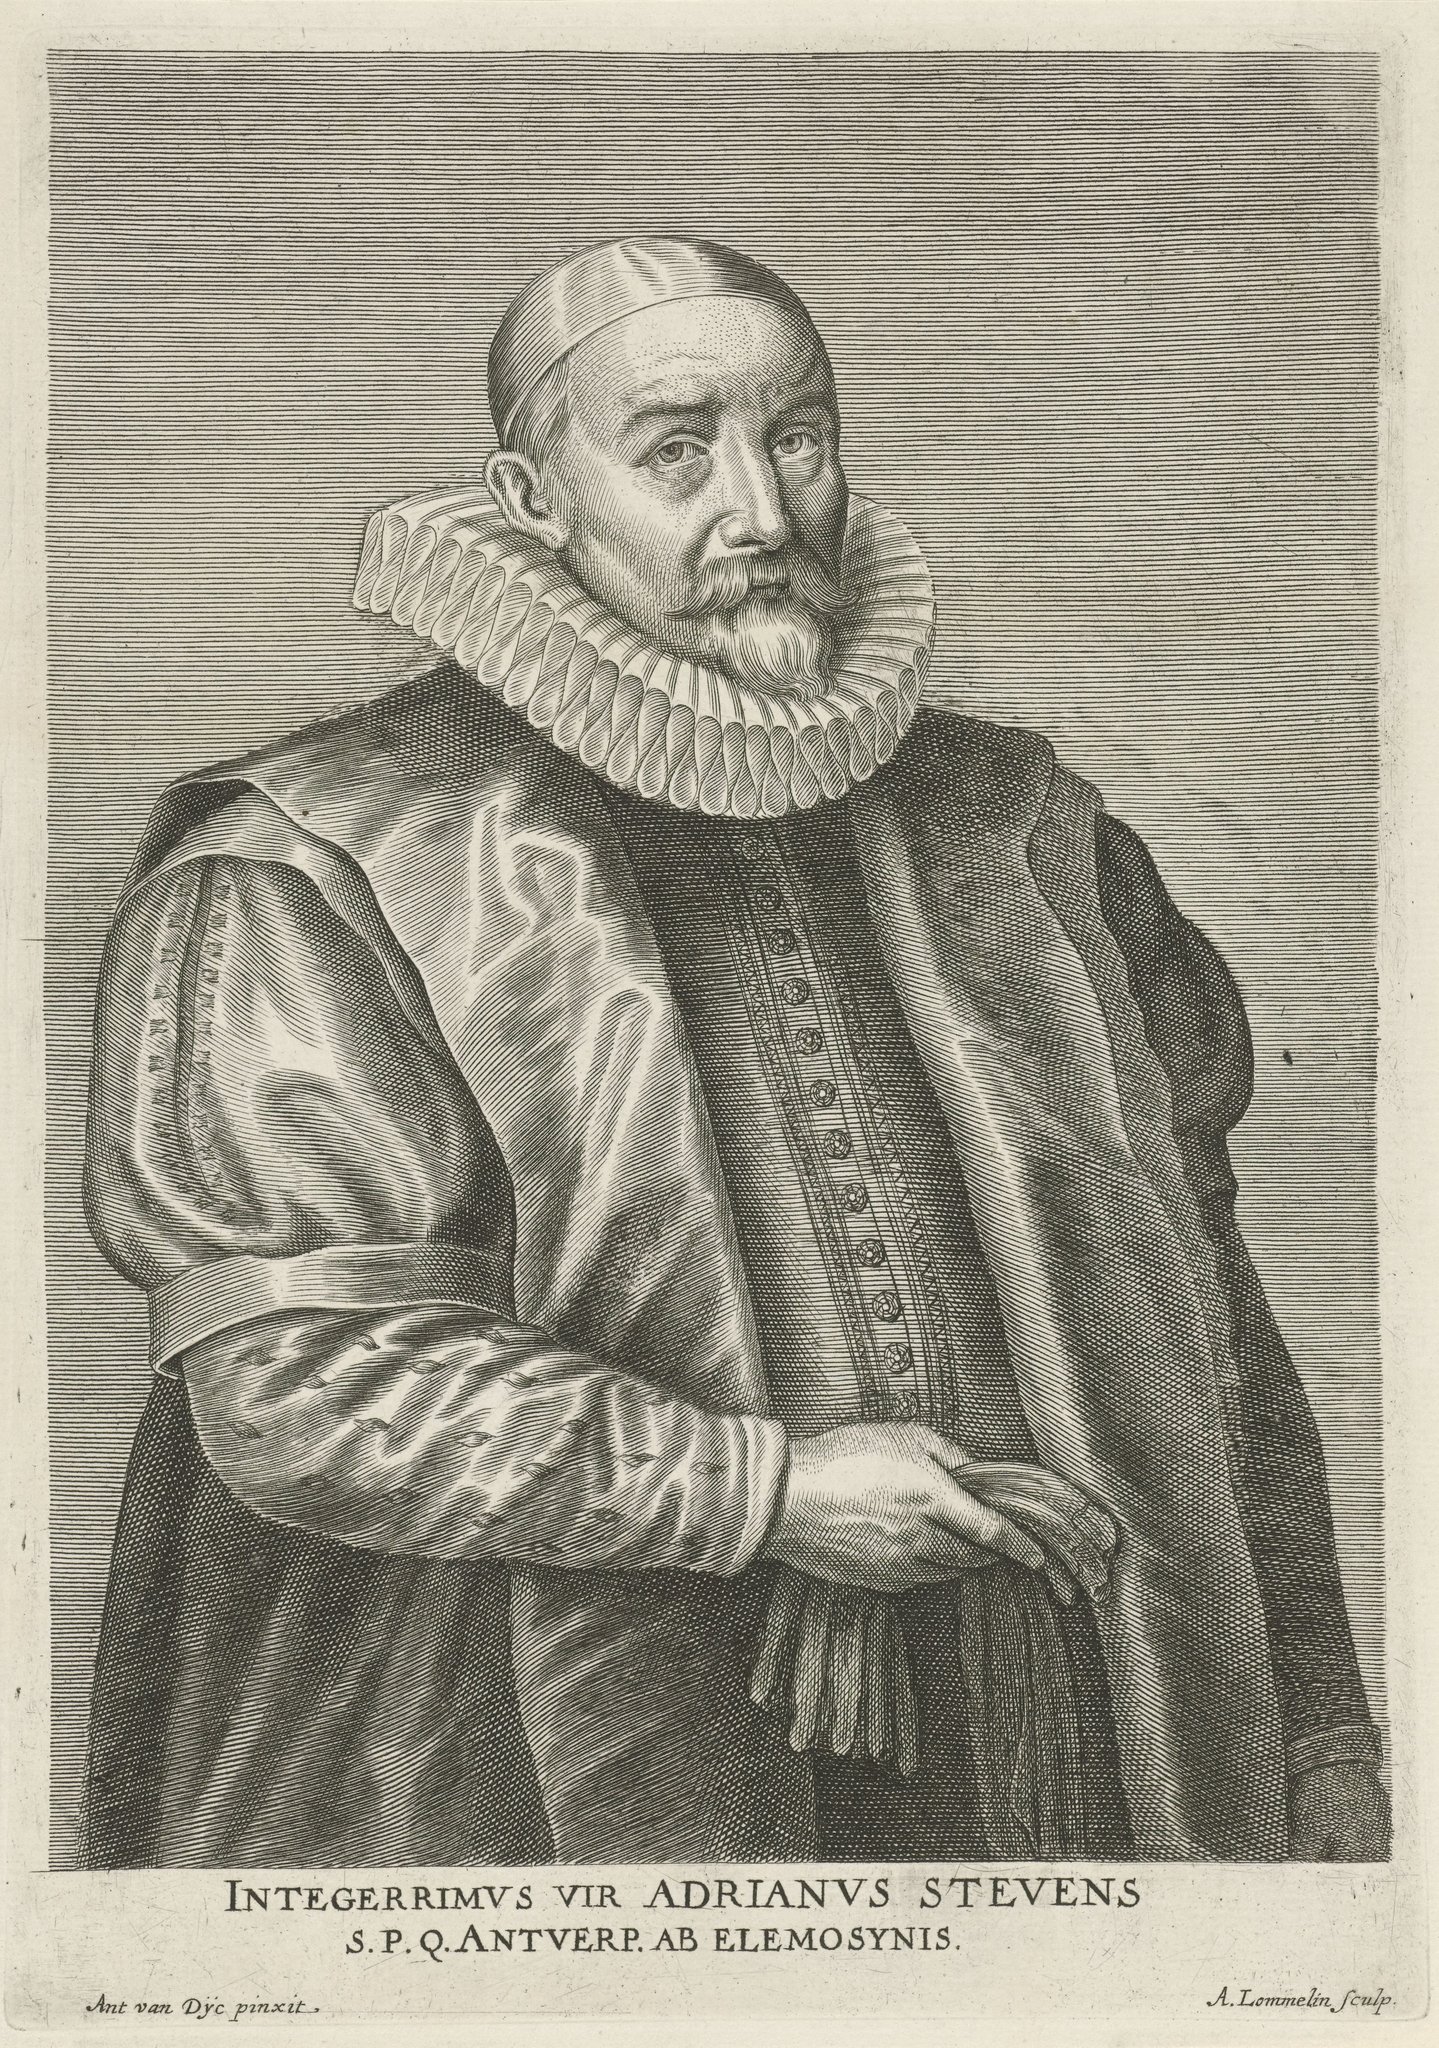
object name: print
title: Portret van Adriaan Stevens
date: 1630-1677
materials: paper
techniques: engraving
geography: antwerp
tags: adriaan stevens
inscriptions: collector's mark: Lugt 240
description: Portret van Adriaan Stevens, aalmoezenier te Antwerpen.